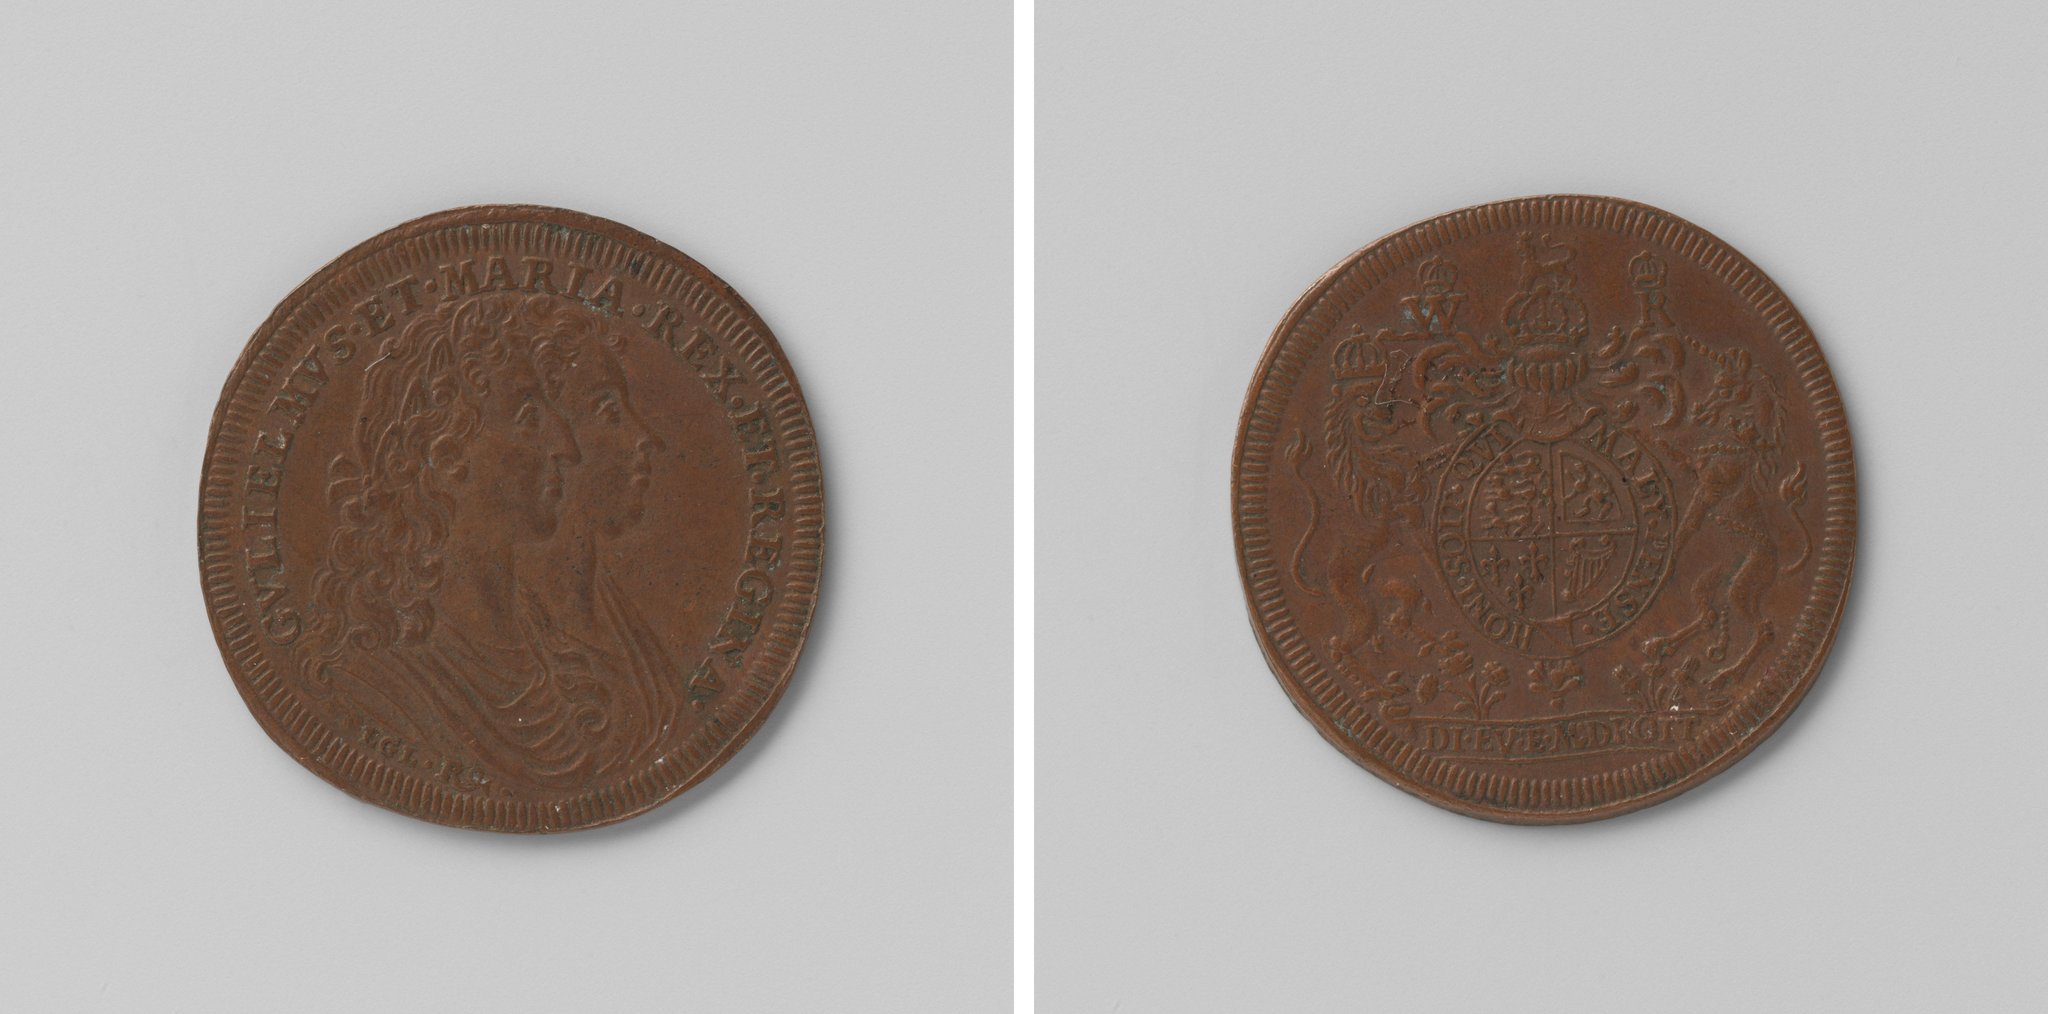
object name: history medal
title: Kroning van Willem III en Maria II Stuart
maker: lazarus gottlieb lauffer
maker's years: 1660-1700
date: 1689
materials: copper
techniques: striking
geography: nuremberg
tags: the hague, william iii (prince of orange and king of england, scotland, and ireland), maria ii stuart (koningin van engeland, schotland en ierland)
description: Koperen penning. Voorzijde: borststuk man met lauwerkrans en vrouw binnen omschrift. Keerzijde: gekroond wapenschild omhangen met de orde van de kouseband geflankeerd door gekroonde leeuw en eenhoorn onder letters W R en boven band met opschrift